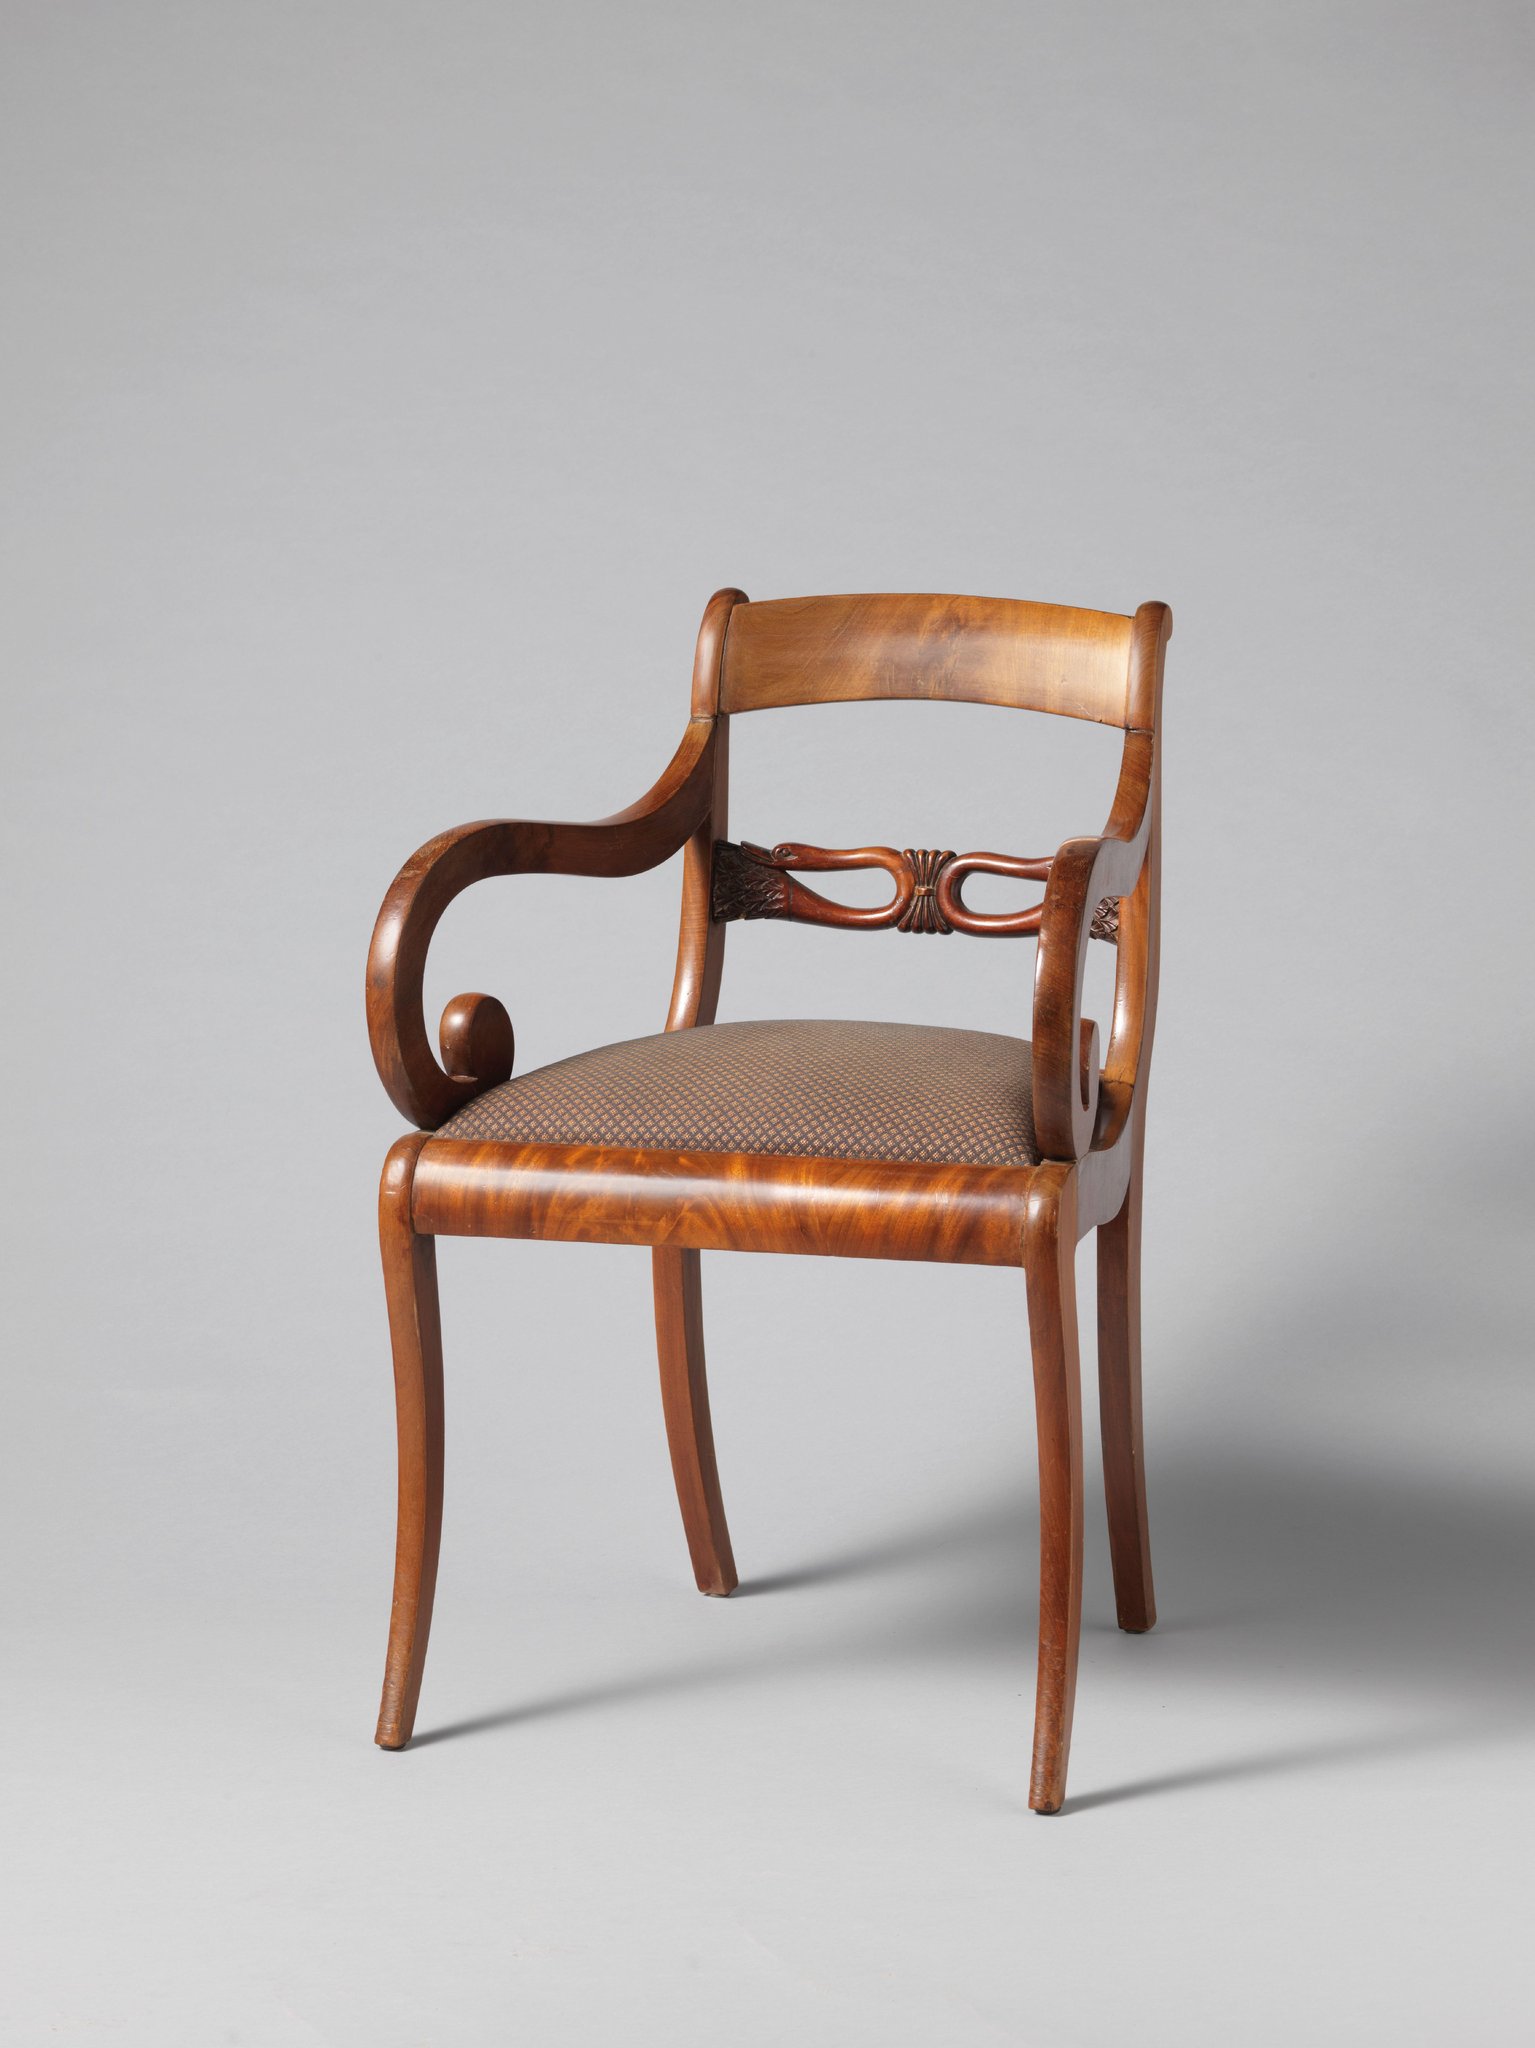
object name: chair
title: Armstoel met zwanen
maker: Anonymous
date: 1830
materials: wood, textile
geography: northern netherlands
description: Armstoel uit een set van tien stoelen en vier armstoelen van deels massief en deels belijmd mahoniehout op iepenhouten kern. Losse beklede zittingen. De vierkante achterpoten wijken achterwaarts. Negen stoelen en een armstoel hebben vierkante, aan de voorzijde iets afgeronde, voorpoten; de rest heeft ronde gedraaide voorpoten zoals deze. De gestrekt S-vormige ruggen hebben een gebeeldhouwde tussenregel met een palmet geflankeerd door twee toegewende, met de halzen terugbuigende zwanen. De platte voluutvormige armleggers lopen hoog in de rug over.